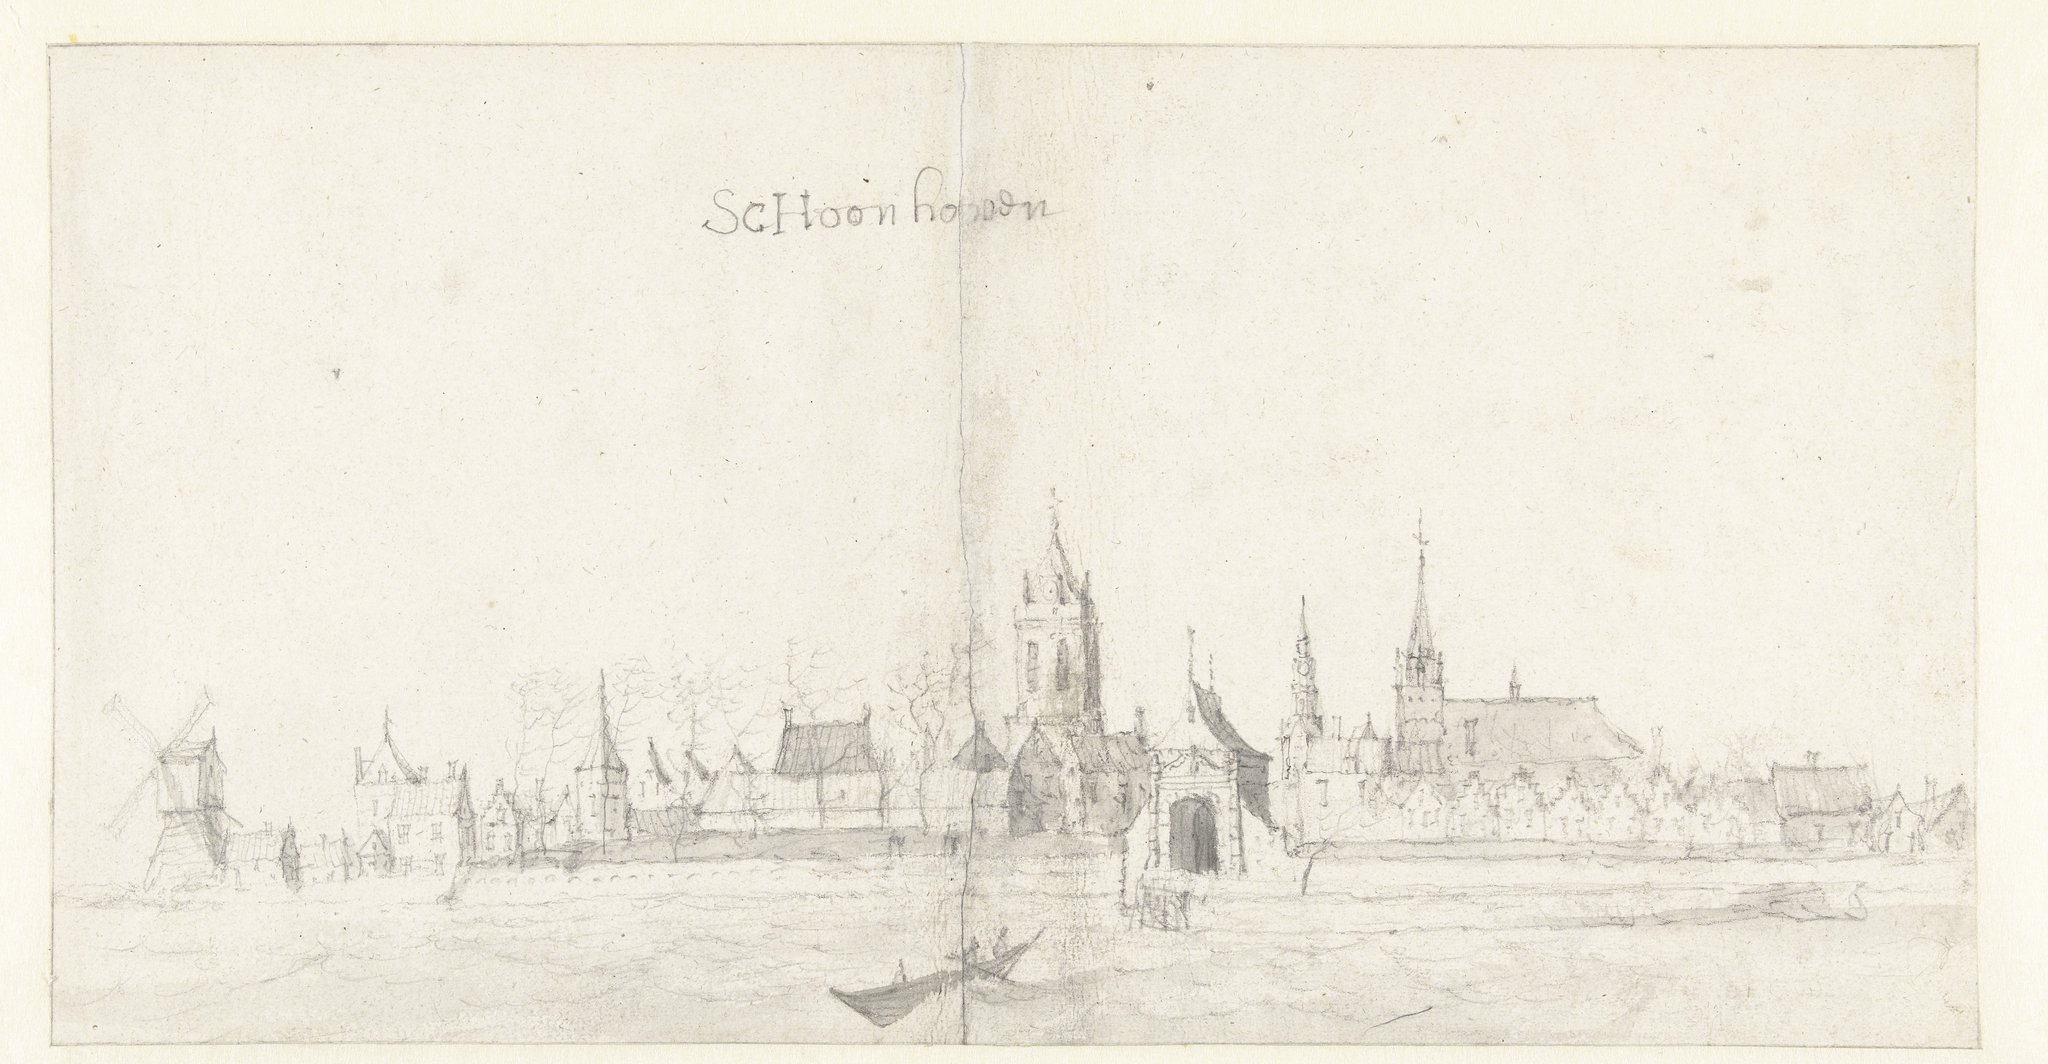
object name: drawing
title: Gezicht op Schoonhoven vanaf de Lek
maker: jan abrahamsz. beerstraten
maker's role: draughtsman, painter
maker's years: 1622-1666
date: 1649-1700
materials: graphite, paper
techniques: brush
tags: prospect of city, town panorama, silhouette of city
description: Aan de hand van de opbouw van de kerktoren is de tekening na 1649 te dateren (D. Mentink, 1981).